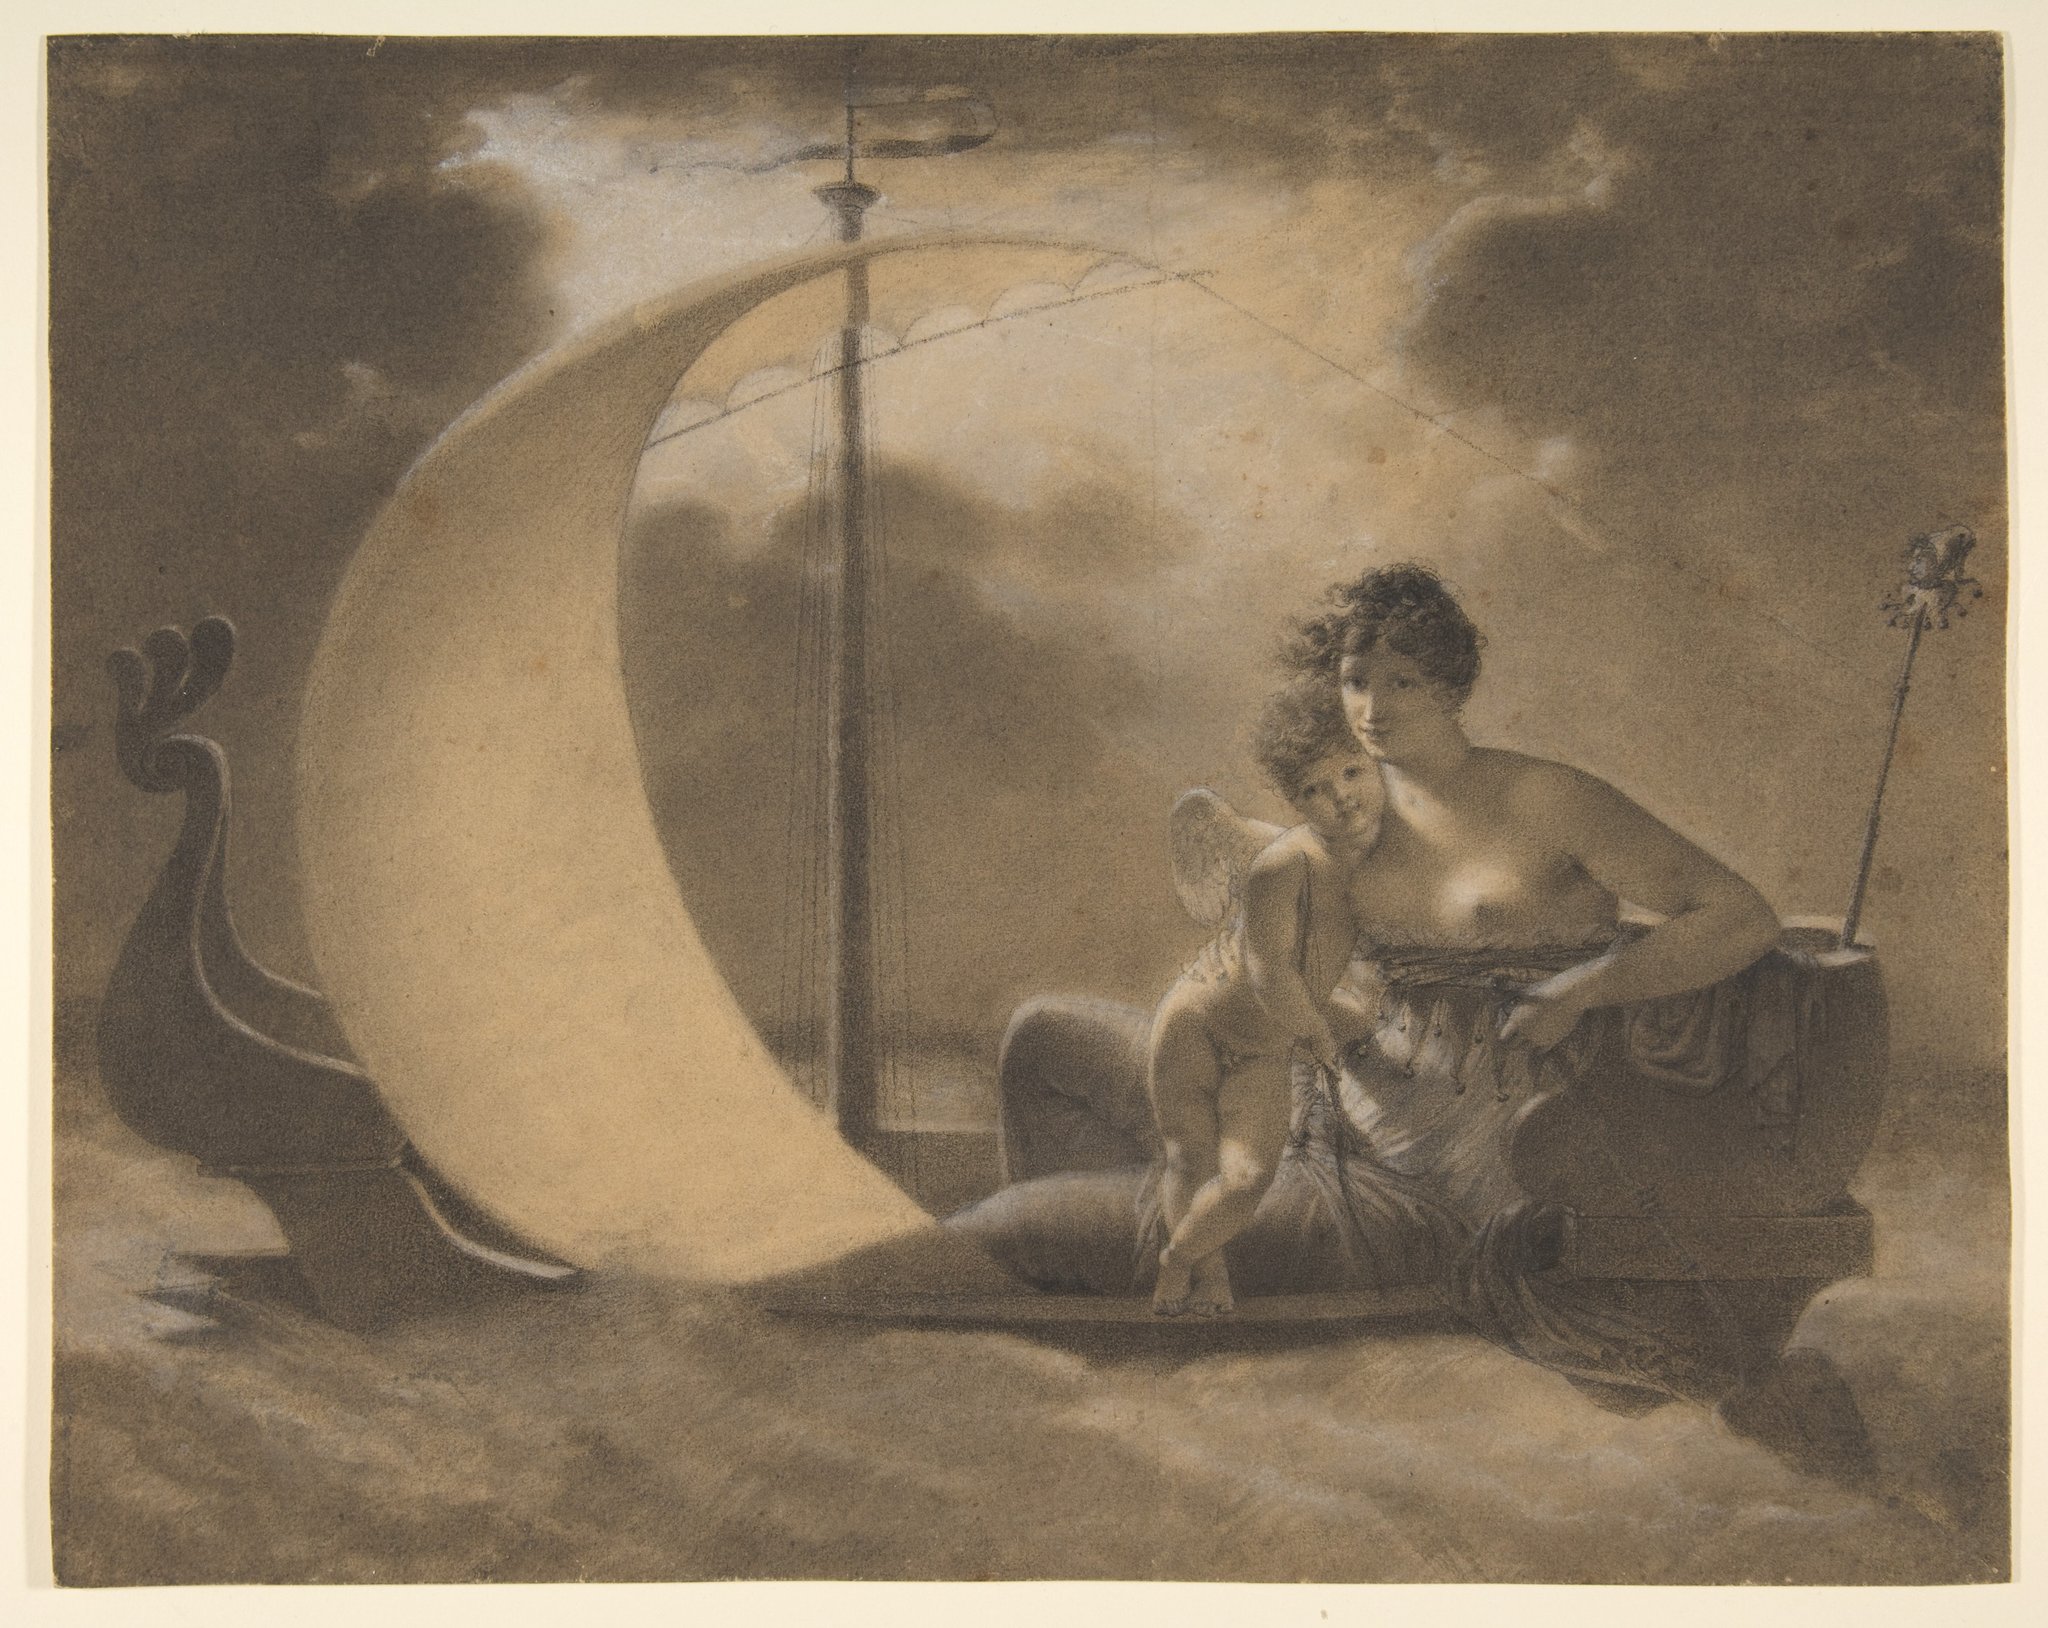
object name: drawing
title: La Folie l'égare (Folly Adrift)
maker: jean-baptiste mallet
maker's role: artist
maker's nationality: french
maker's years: 1759-1835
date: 1810-1820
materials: chalk, paper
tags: women,putti,boats